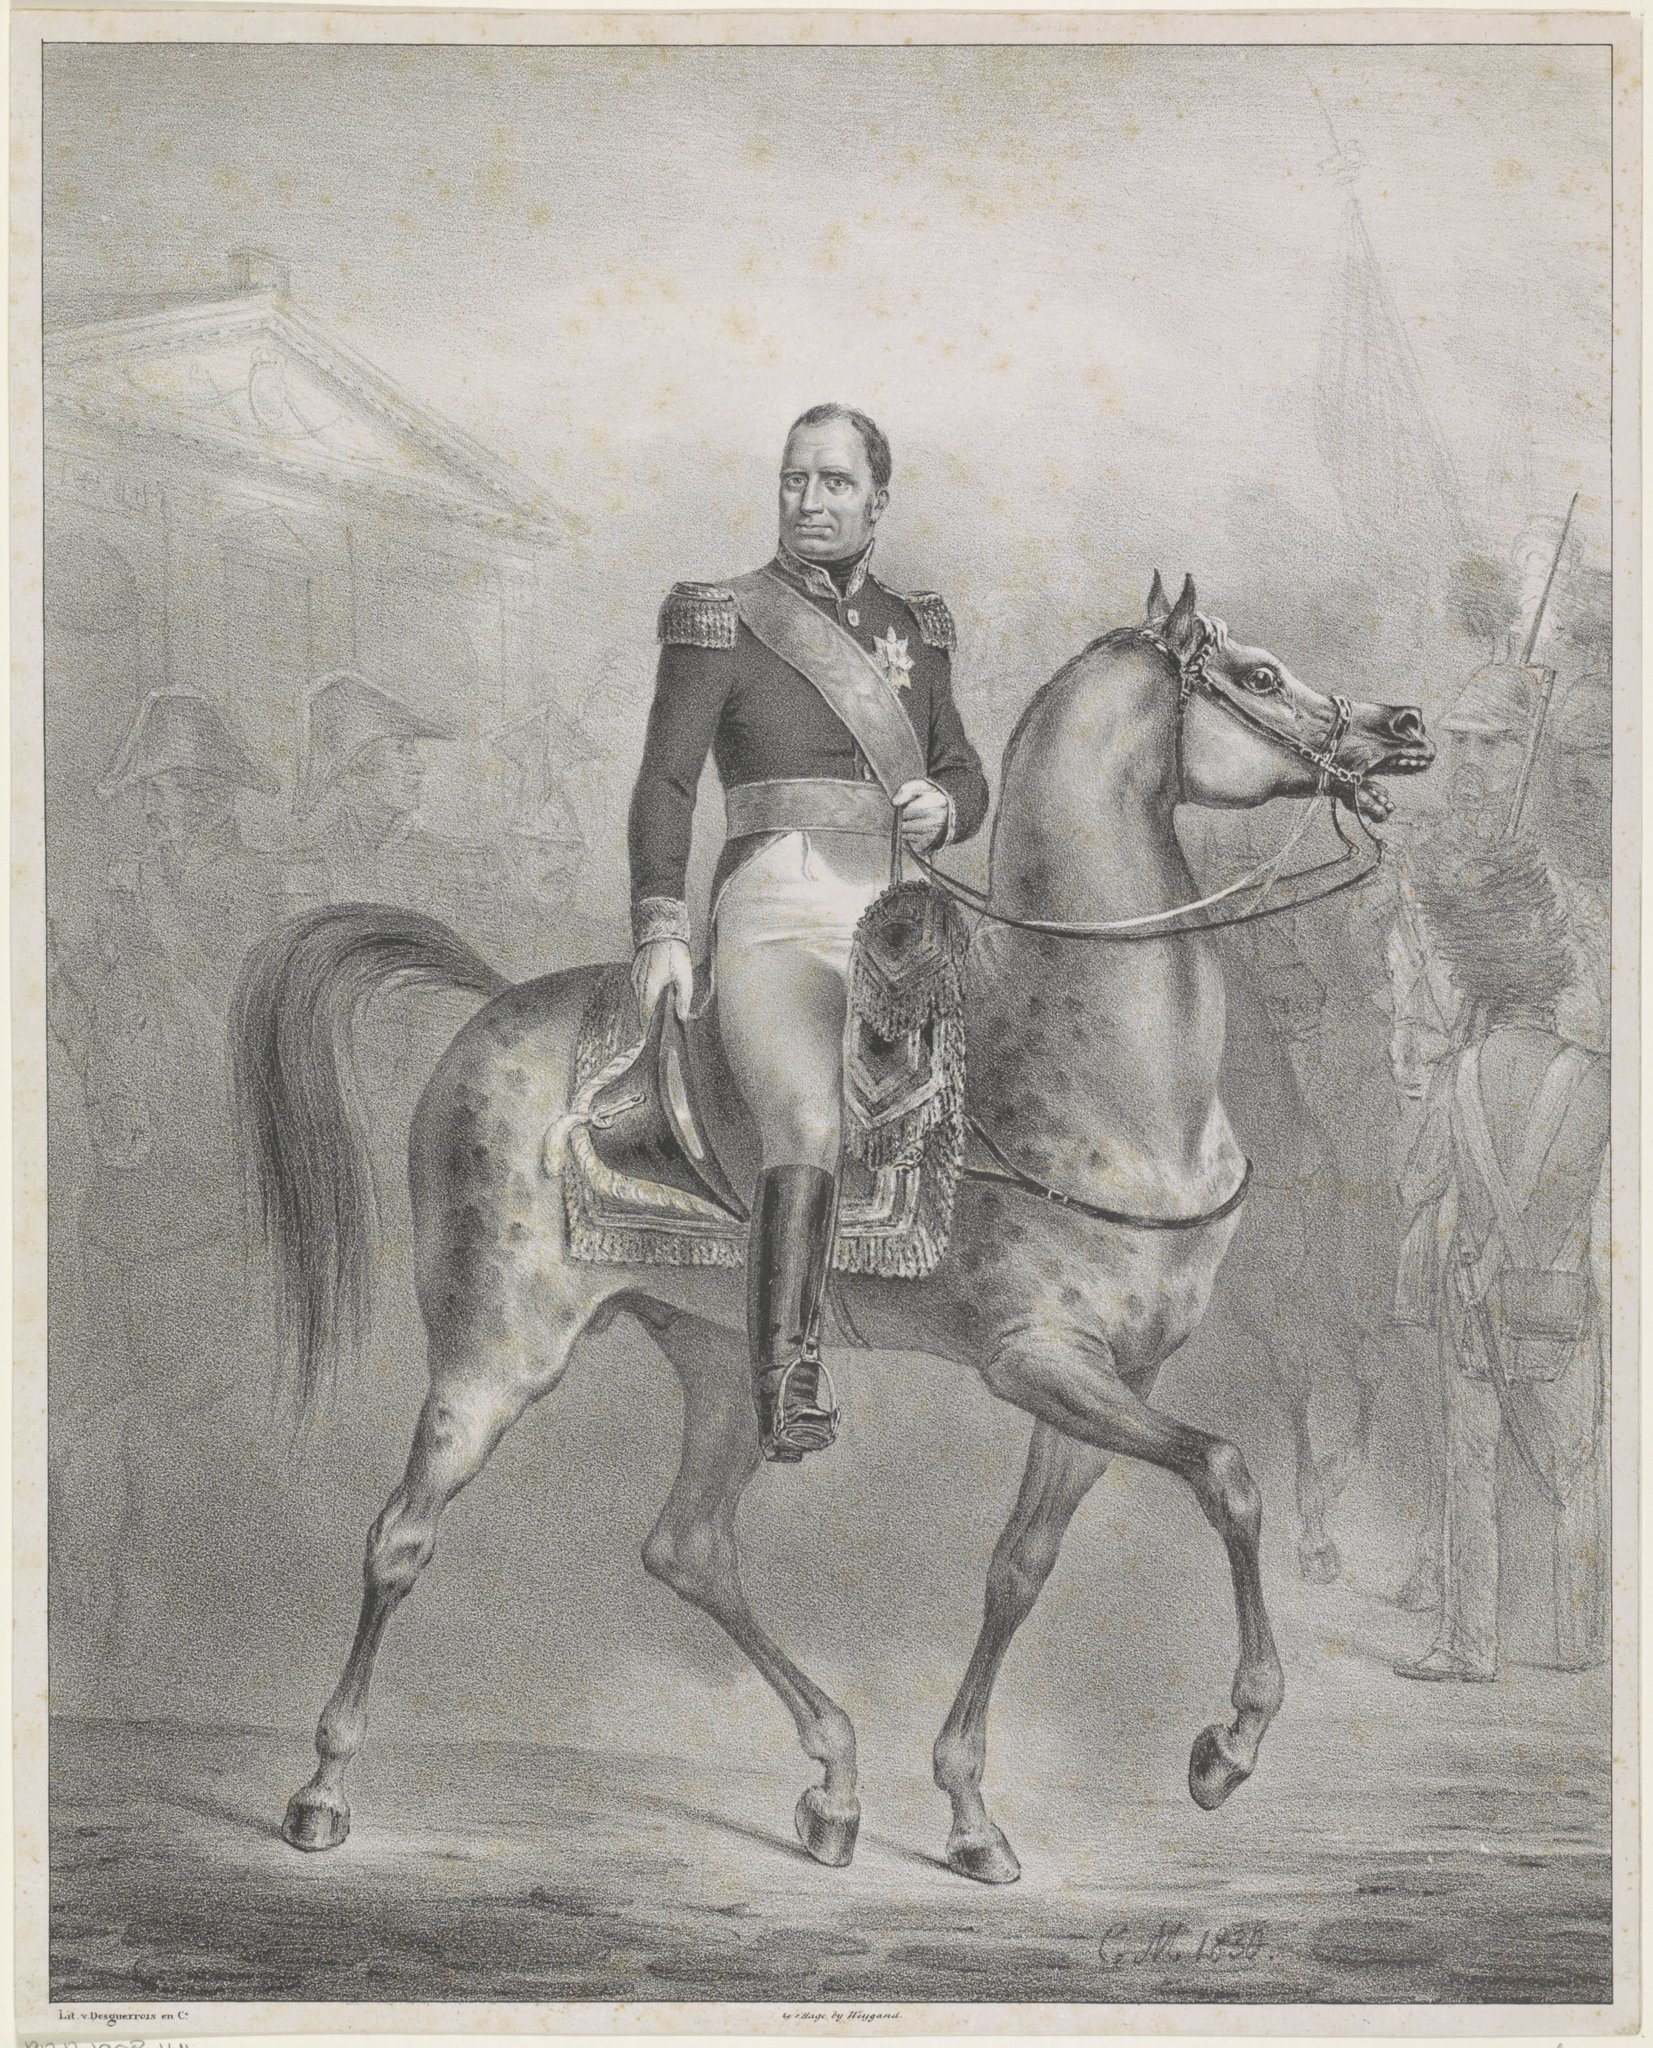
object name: print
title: Ruiterportret van Willem I Frederik, koning der Nederlanden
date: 1830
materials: paper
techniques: lithograph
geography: amsterdam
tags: the hague, berlin, william i of the netherlands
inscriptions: collector's mark: Lugt 2228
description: De hier vermelde titel verwijst naar de hoogst verkregen titel van de geportretteerde, niet per se naar de titel die de geportretteerde op deze voorstelling draagt.